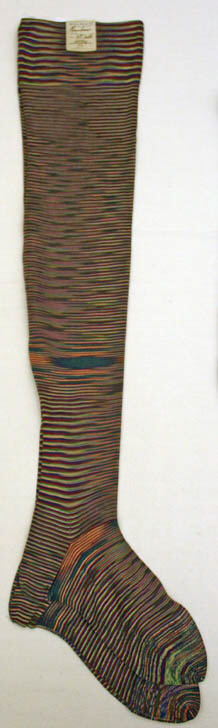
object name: stocking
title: Stockings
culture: french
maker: mr. callum hosiery co.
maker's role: designer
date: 1880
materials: silk